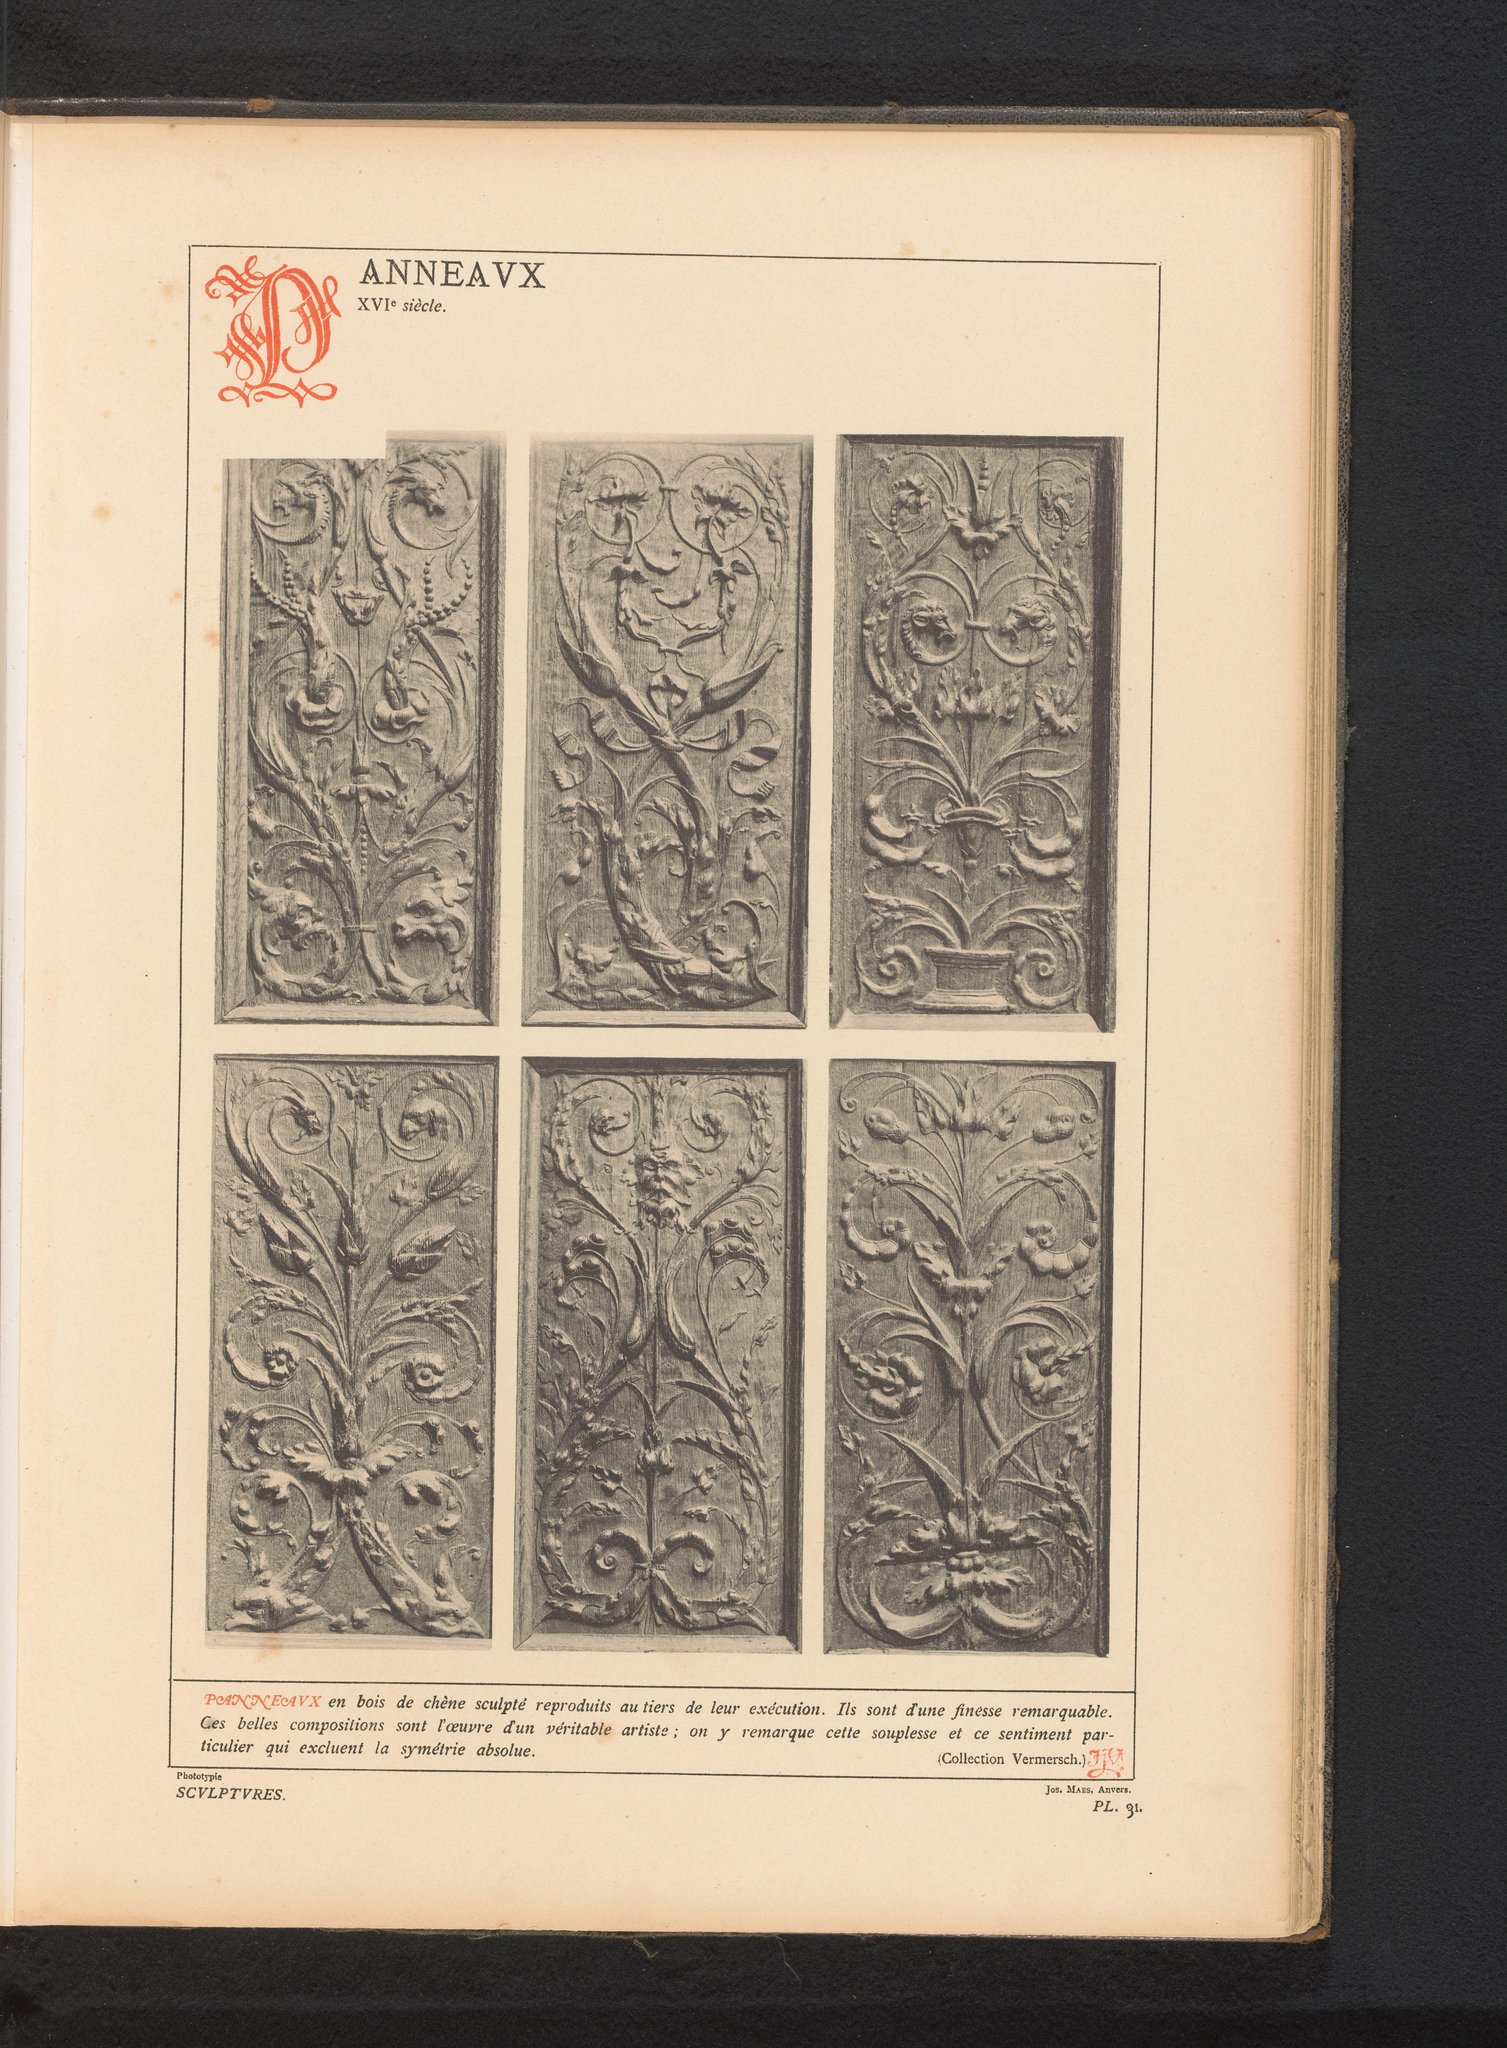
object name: page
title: Eikenhouten panelen, gedecoreerd met bloem- en plantmotieven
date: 1881-1889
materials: paper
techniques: photograph, photolithography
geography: antwerp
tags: sculpture, handicrafts ~ wood, timber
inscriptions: inscription: ‘PANNEAUX en bois (...)’, inscription: ‘SCULPTURES. PL. 31.’, monogram: ‘JJvY’